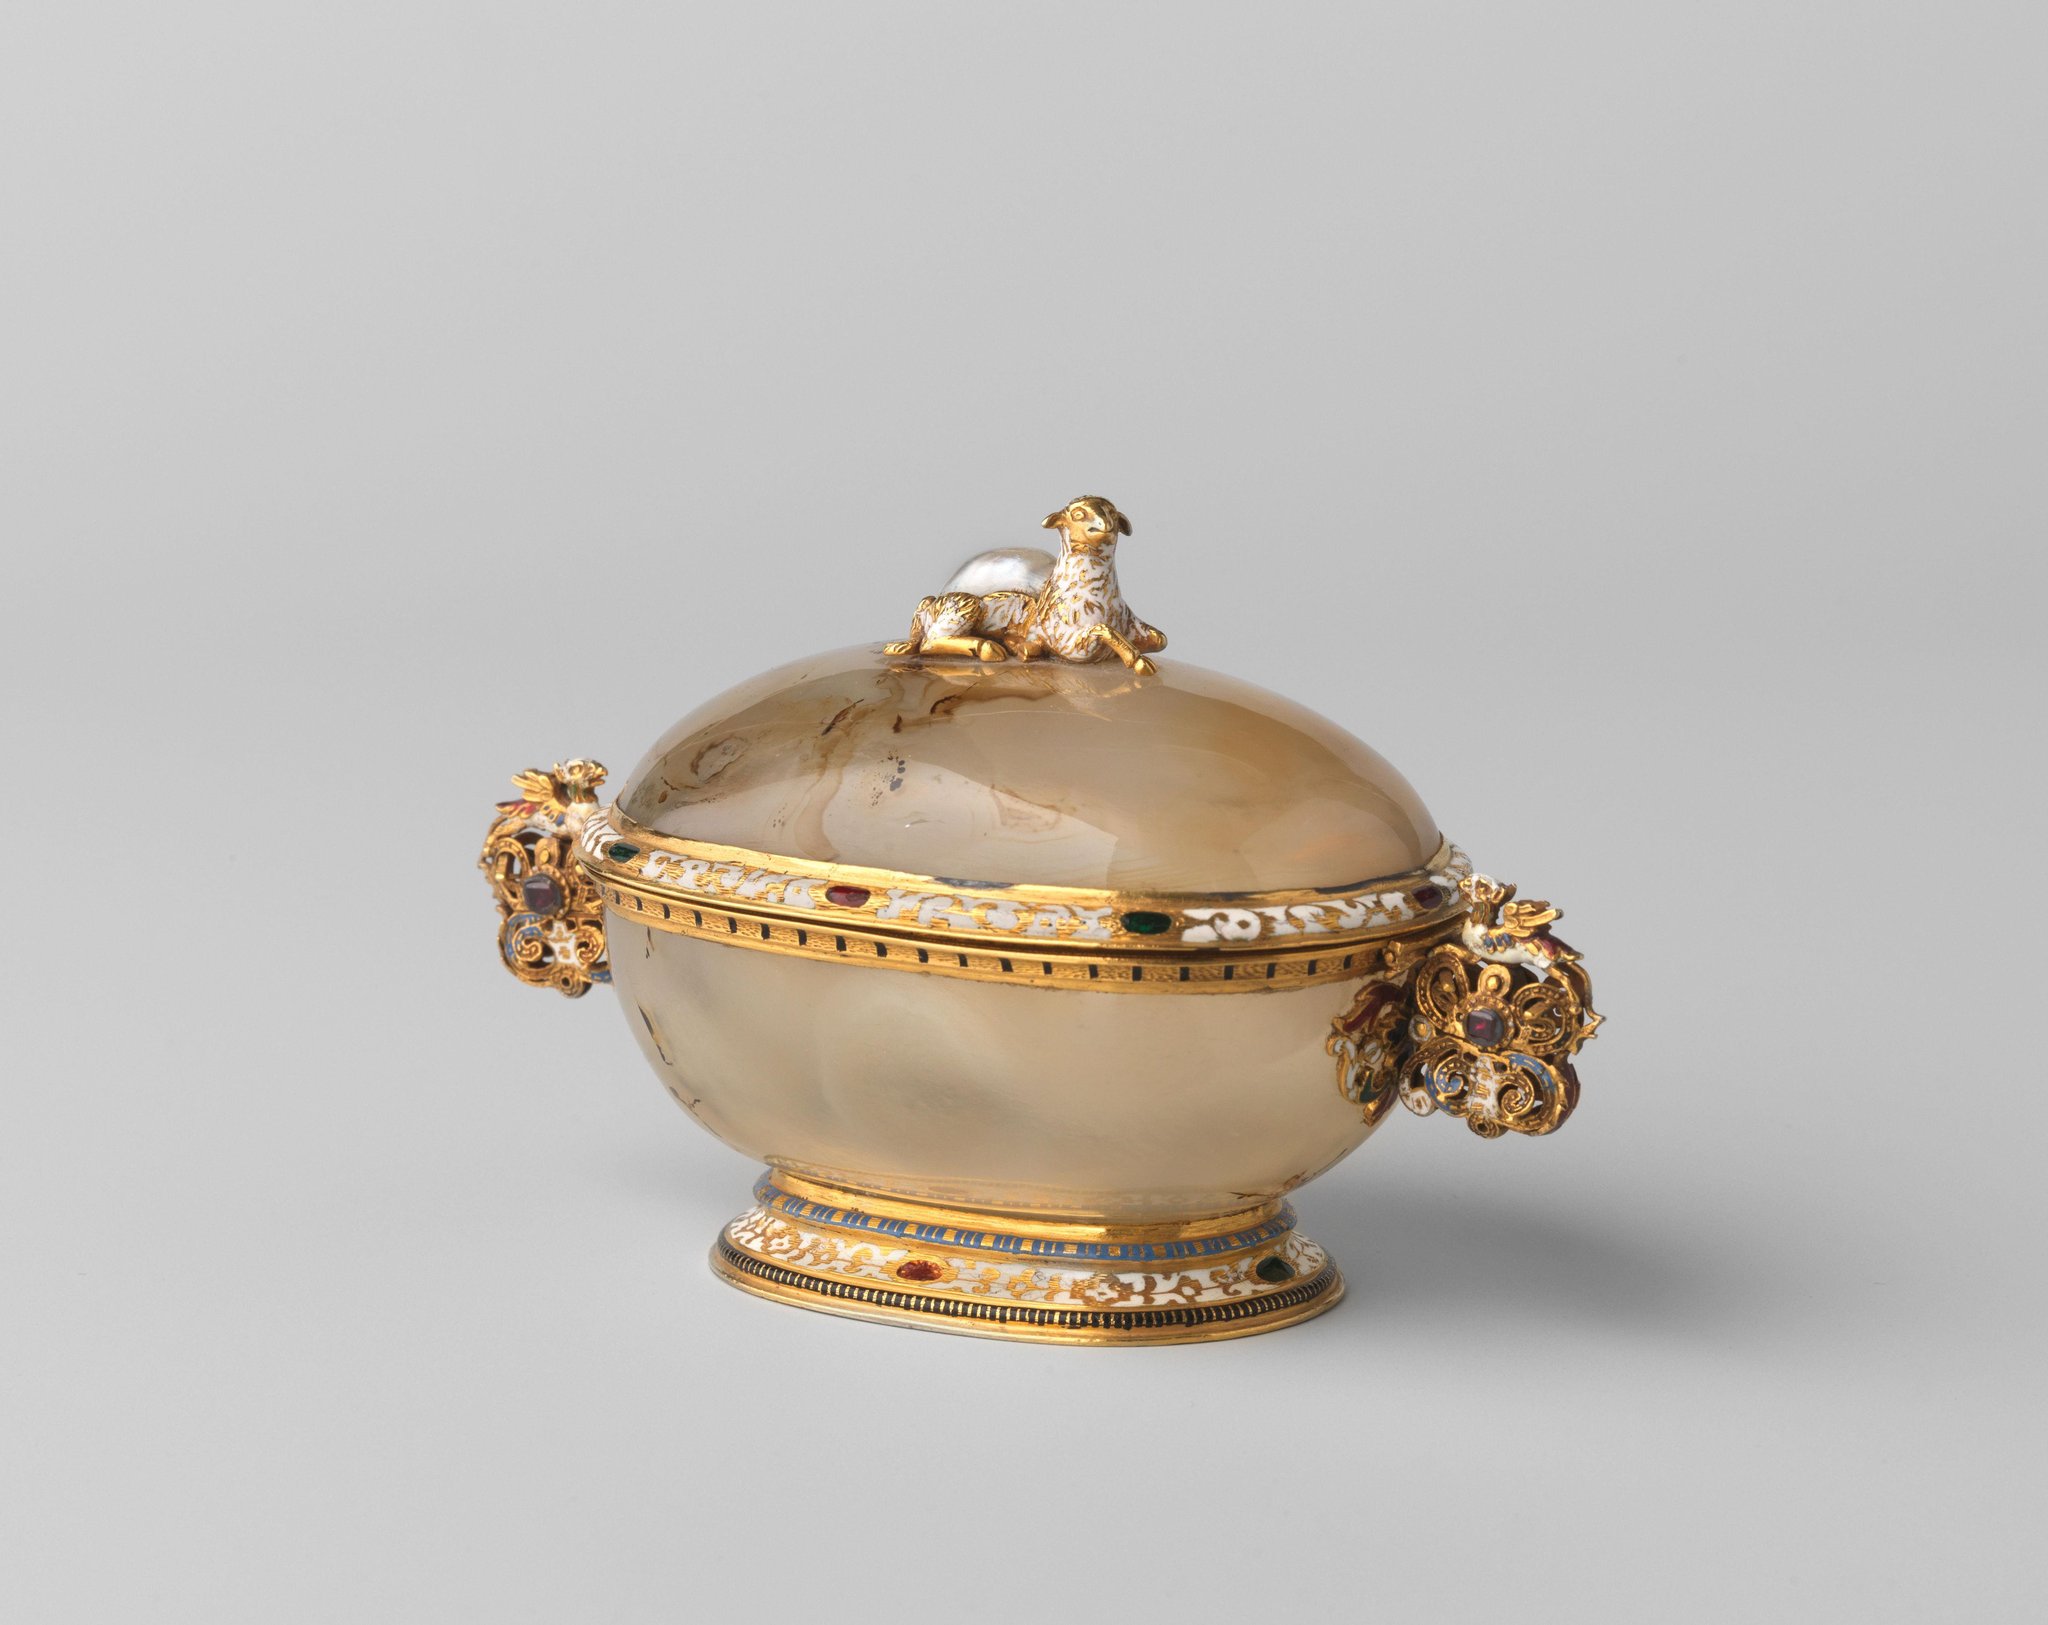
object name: vessel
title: Deksel van dekschaaltje van doorschijnend agaat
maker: Anonymous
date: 1575-1600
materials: stone, gold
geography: germany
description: Dekselrand vertoont gouden motieven op witte fond. Op het deksel een lam van goud en wit met barokparel als rug.